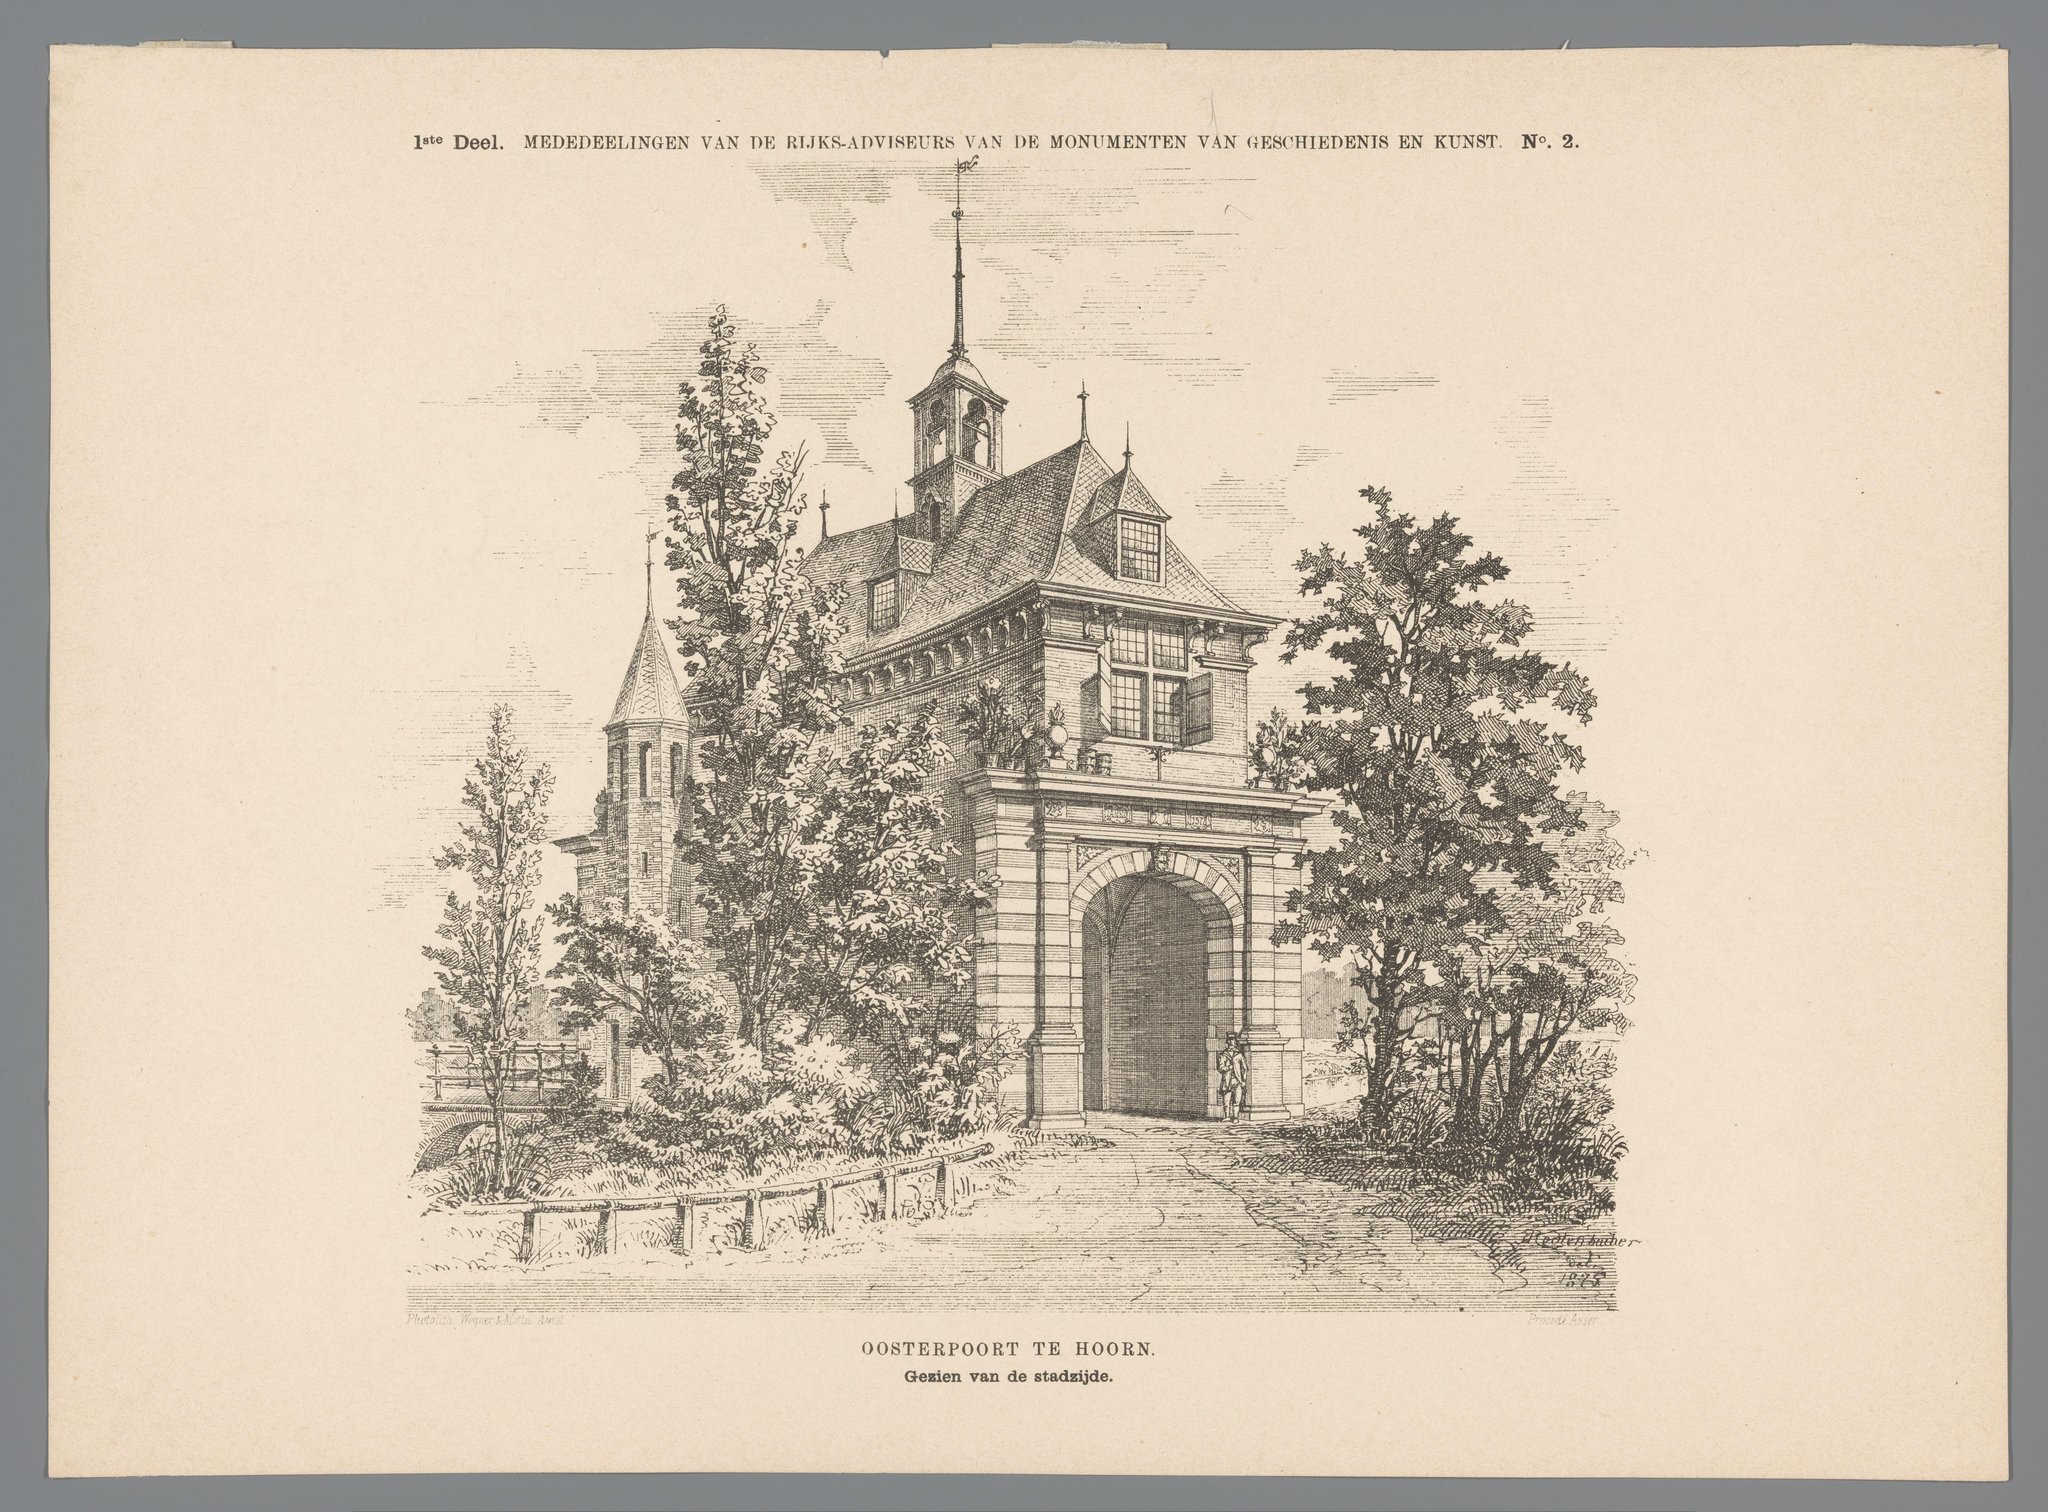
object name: book illustration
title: Oosterpoort te Hoorn. Gezien van de stadzijde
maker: Anonymous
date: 1876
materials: paper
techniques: photolithography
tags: city-gate, hoorn (north holland)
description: Afdruk uit: Mededeelingen van de Rijks-adviseurs voor de monumenten van geschiedenis en kunst. Den Haag: s.n., 1876-1878, dl. 1, nr. 1 (1876), na p. 28.